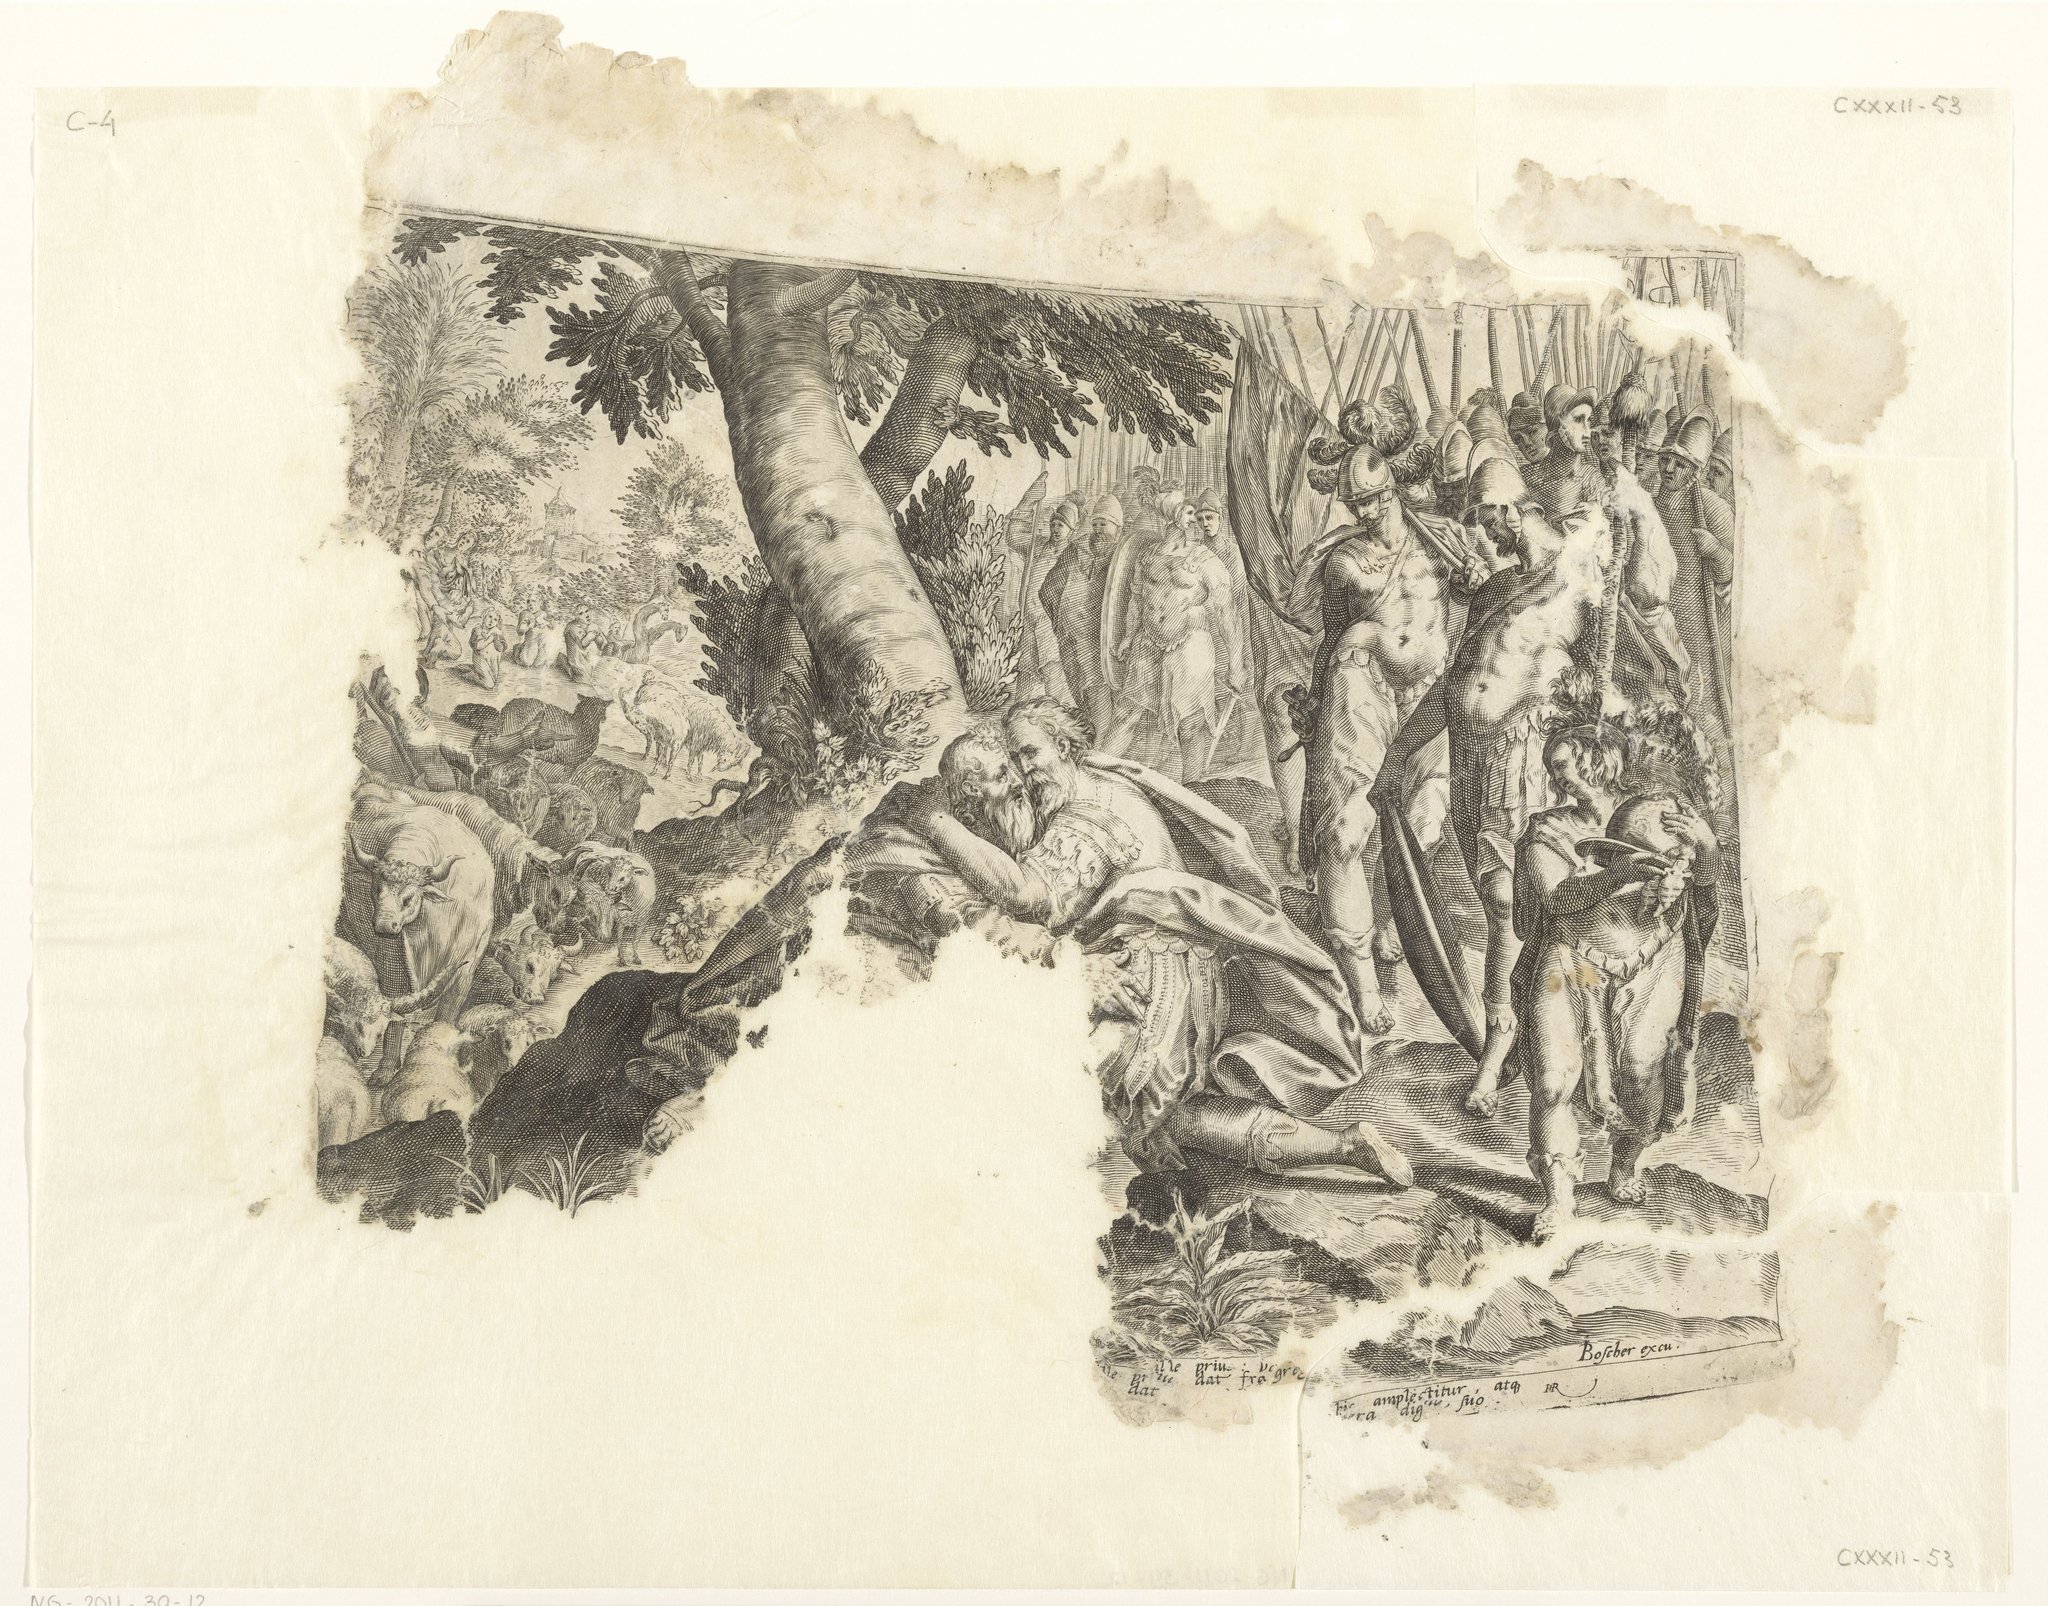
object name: print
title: Verzoening van Jakob en Esau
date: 1580-1596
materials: paper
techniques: engraving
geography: northern netherlands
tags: the meeting between esau and jacob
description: Tot dusverre was deze prent alleen bekend in een latere editie met het adres van C.J. Visscher in het door hem uitgegeven Theatrum Biblicum uit 1643, zie RP-P-1976-30-39. De prenten in de Nova Zembla collectie zijn tijdens een expeditie van Willem Barendsz en Jacob van Heemskerk in 1596-1597 noodgedwongen in het winterkamp, het ‘Behouden Huis’, op het eiland achtergelaten. De prenten waren in één of meerdere stapels als handelswaar meegenomen vanuit Amsterdam. Bijna drie eeuwen later, in 1871, keerde de Noor Elling Carlsen terug naar Nova Zembla en vond daar de restanten van het ‘Behouden Huis, inclusief een groot deel van de inventaris. Een deel van de prenten, in de vorm van aaneengekoekte kluiten, werd toen ook teruggevonden. De papierkluiten waren soms op meerdere plekken gebroken. Tussen 1975-1979 zijn de prenten van elkaar gescheiden. Dit leverde in totaal ca. 1000 fragmenten van ca. 400 afdrukken van ca. 150 verschillende prenten op. Voor zover mogelijk zijn de fragmenten samengevoegd en zijn de prenten gereconstrueerd.